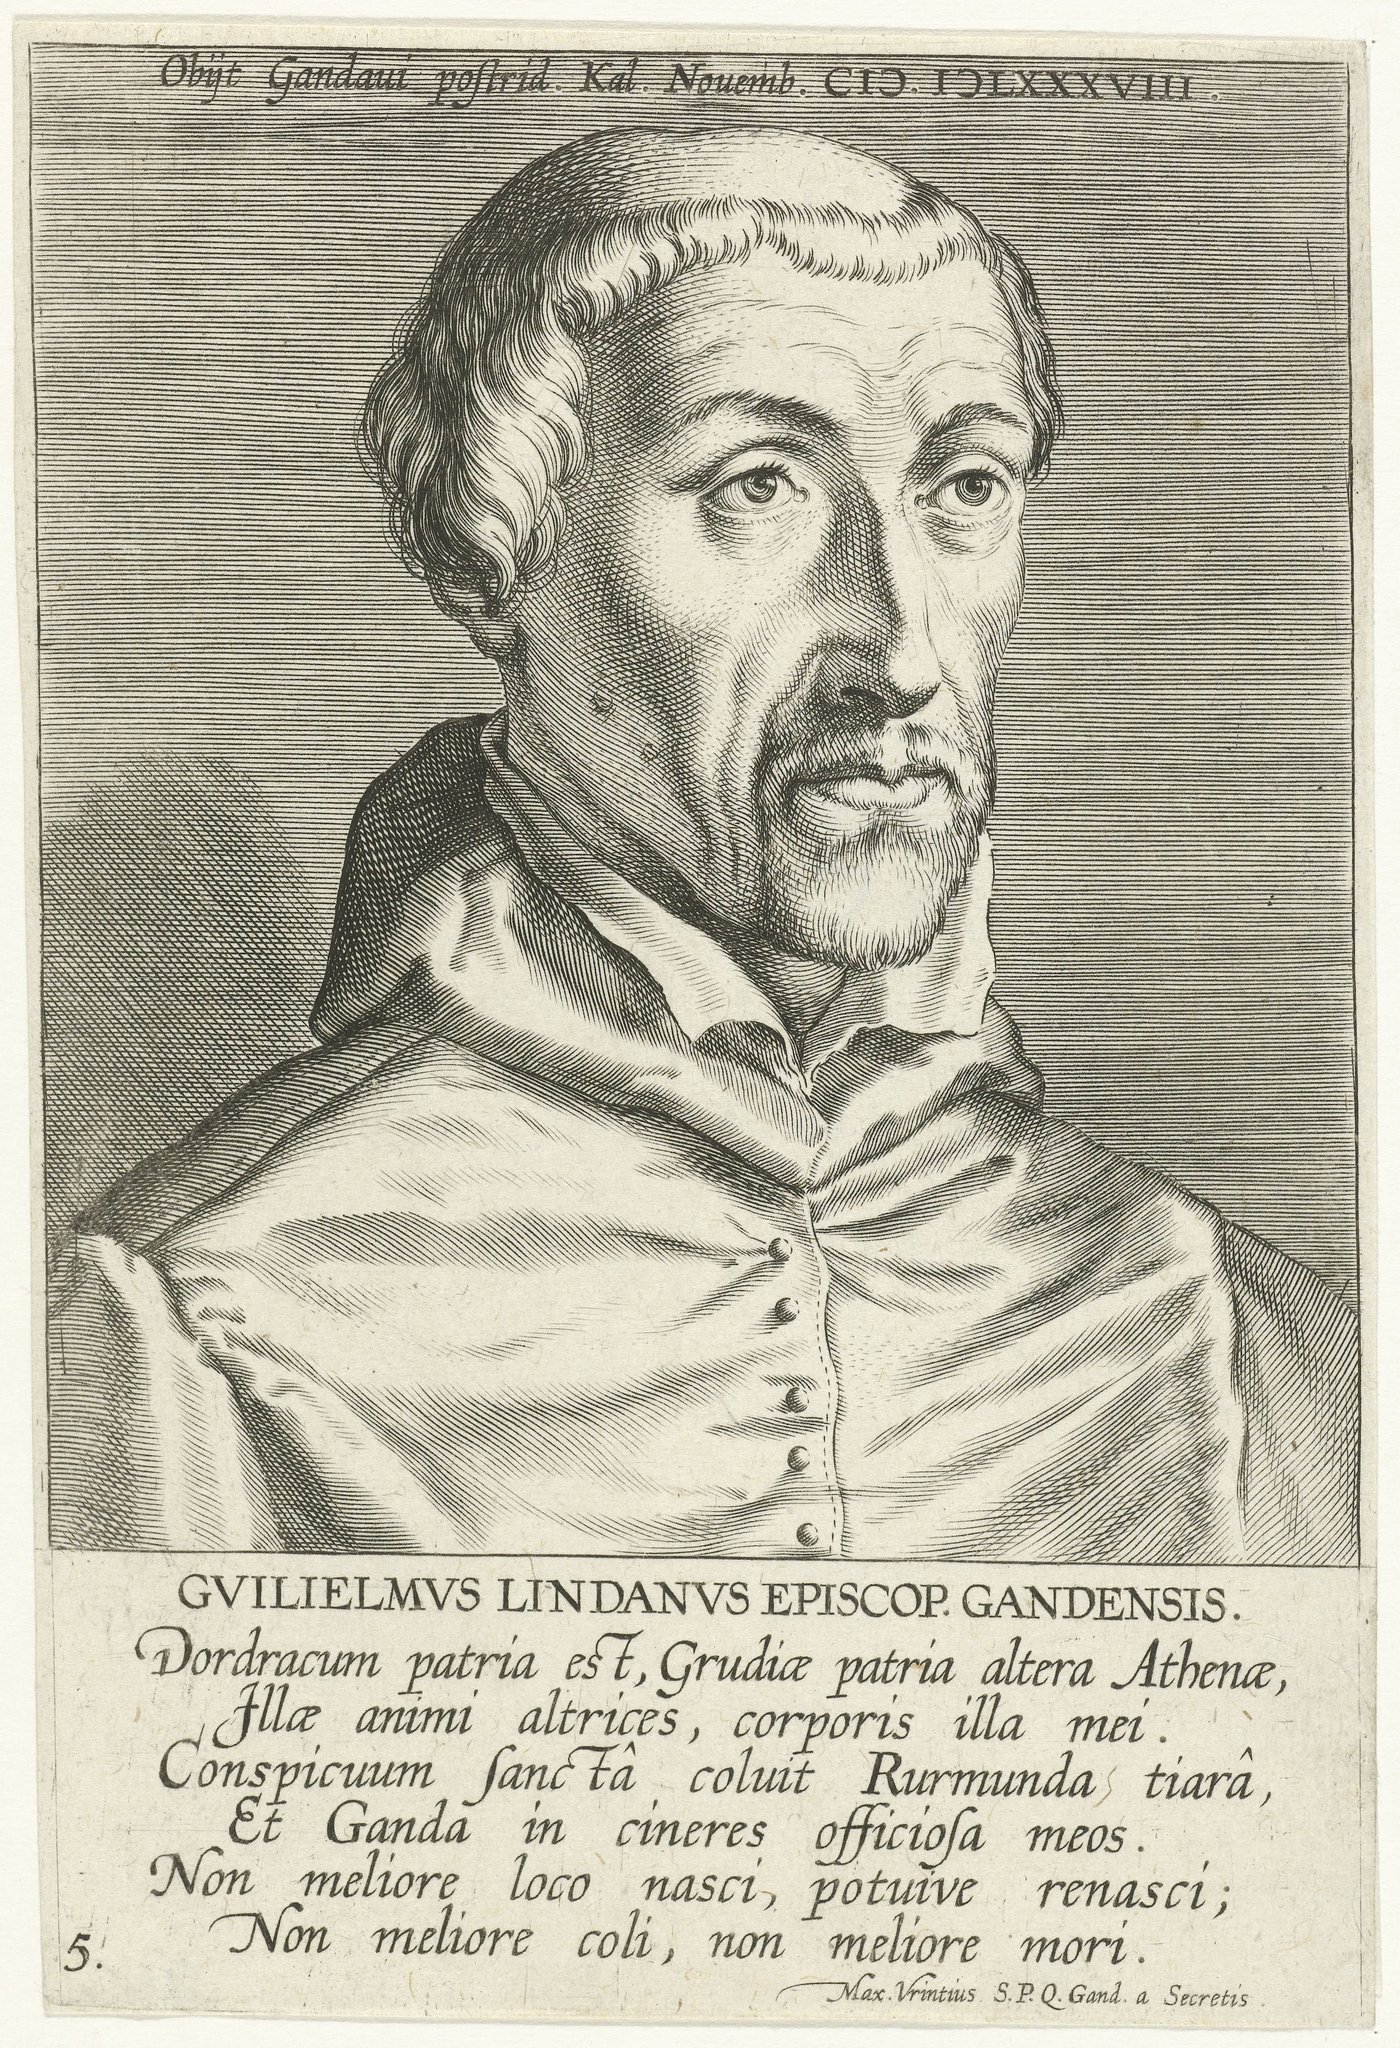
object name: print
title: Illustrium Galliae Belgicae scriptorum icones et elogi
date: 1604-1608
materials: paper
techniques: engraving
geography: antwerp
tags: dordrecht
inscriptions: collector's mark: Lugt 2228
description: Portret van Willem van der Linden, bisschop van Gent. Buste naar rechts. De prent heeft een Latijns boven- en onderschrift en maakt deel uit van een serie van beroemde Nederlandse en Vlaamse geleerden.